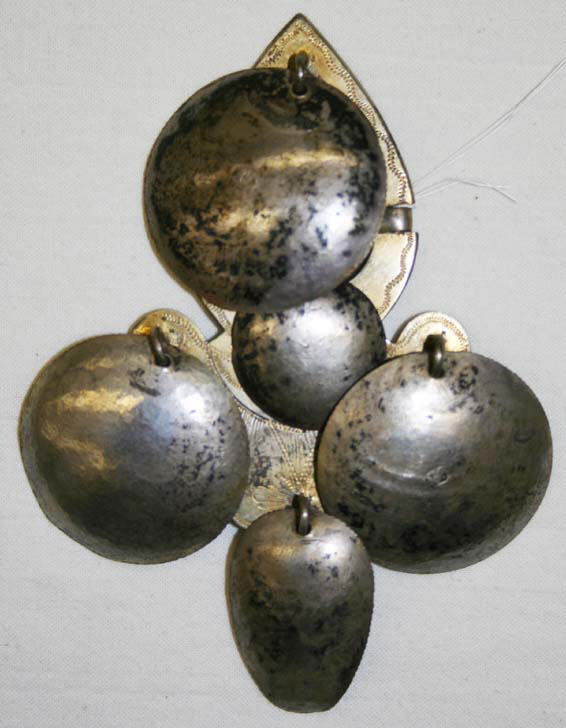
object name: brooch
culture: norwegian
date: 1801-1900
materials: metal